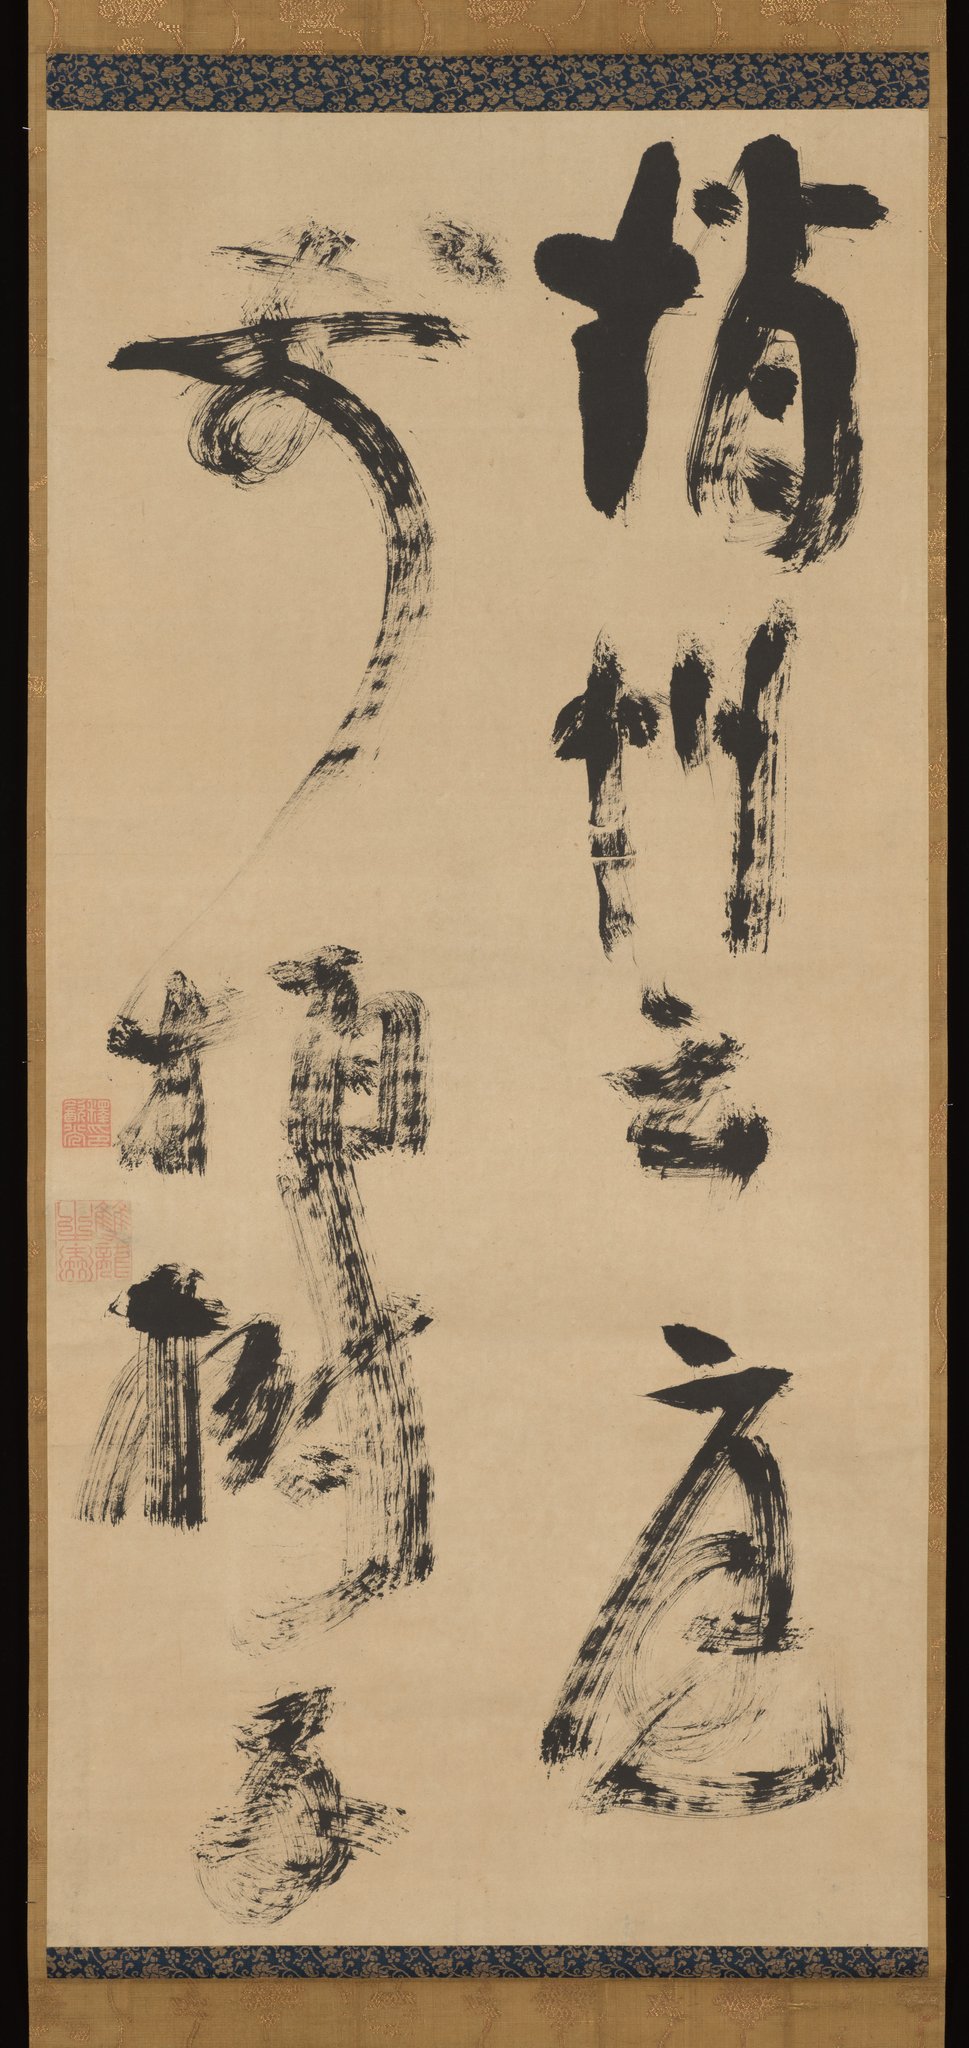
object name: hanging scroll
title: Zen Koan on Cypress Trees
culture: japanese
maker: jiun onkō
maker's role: artist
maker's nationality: japanese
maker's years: 1718-1804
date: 1767-1800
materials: ink, paper